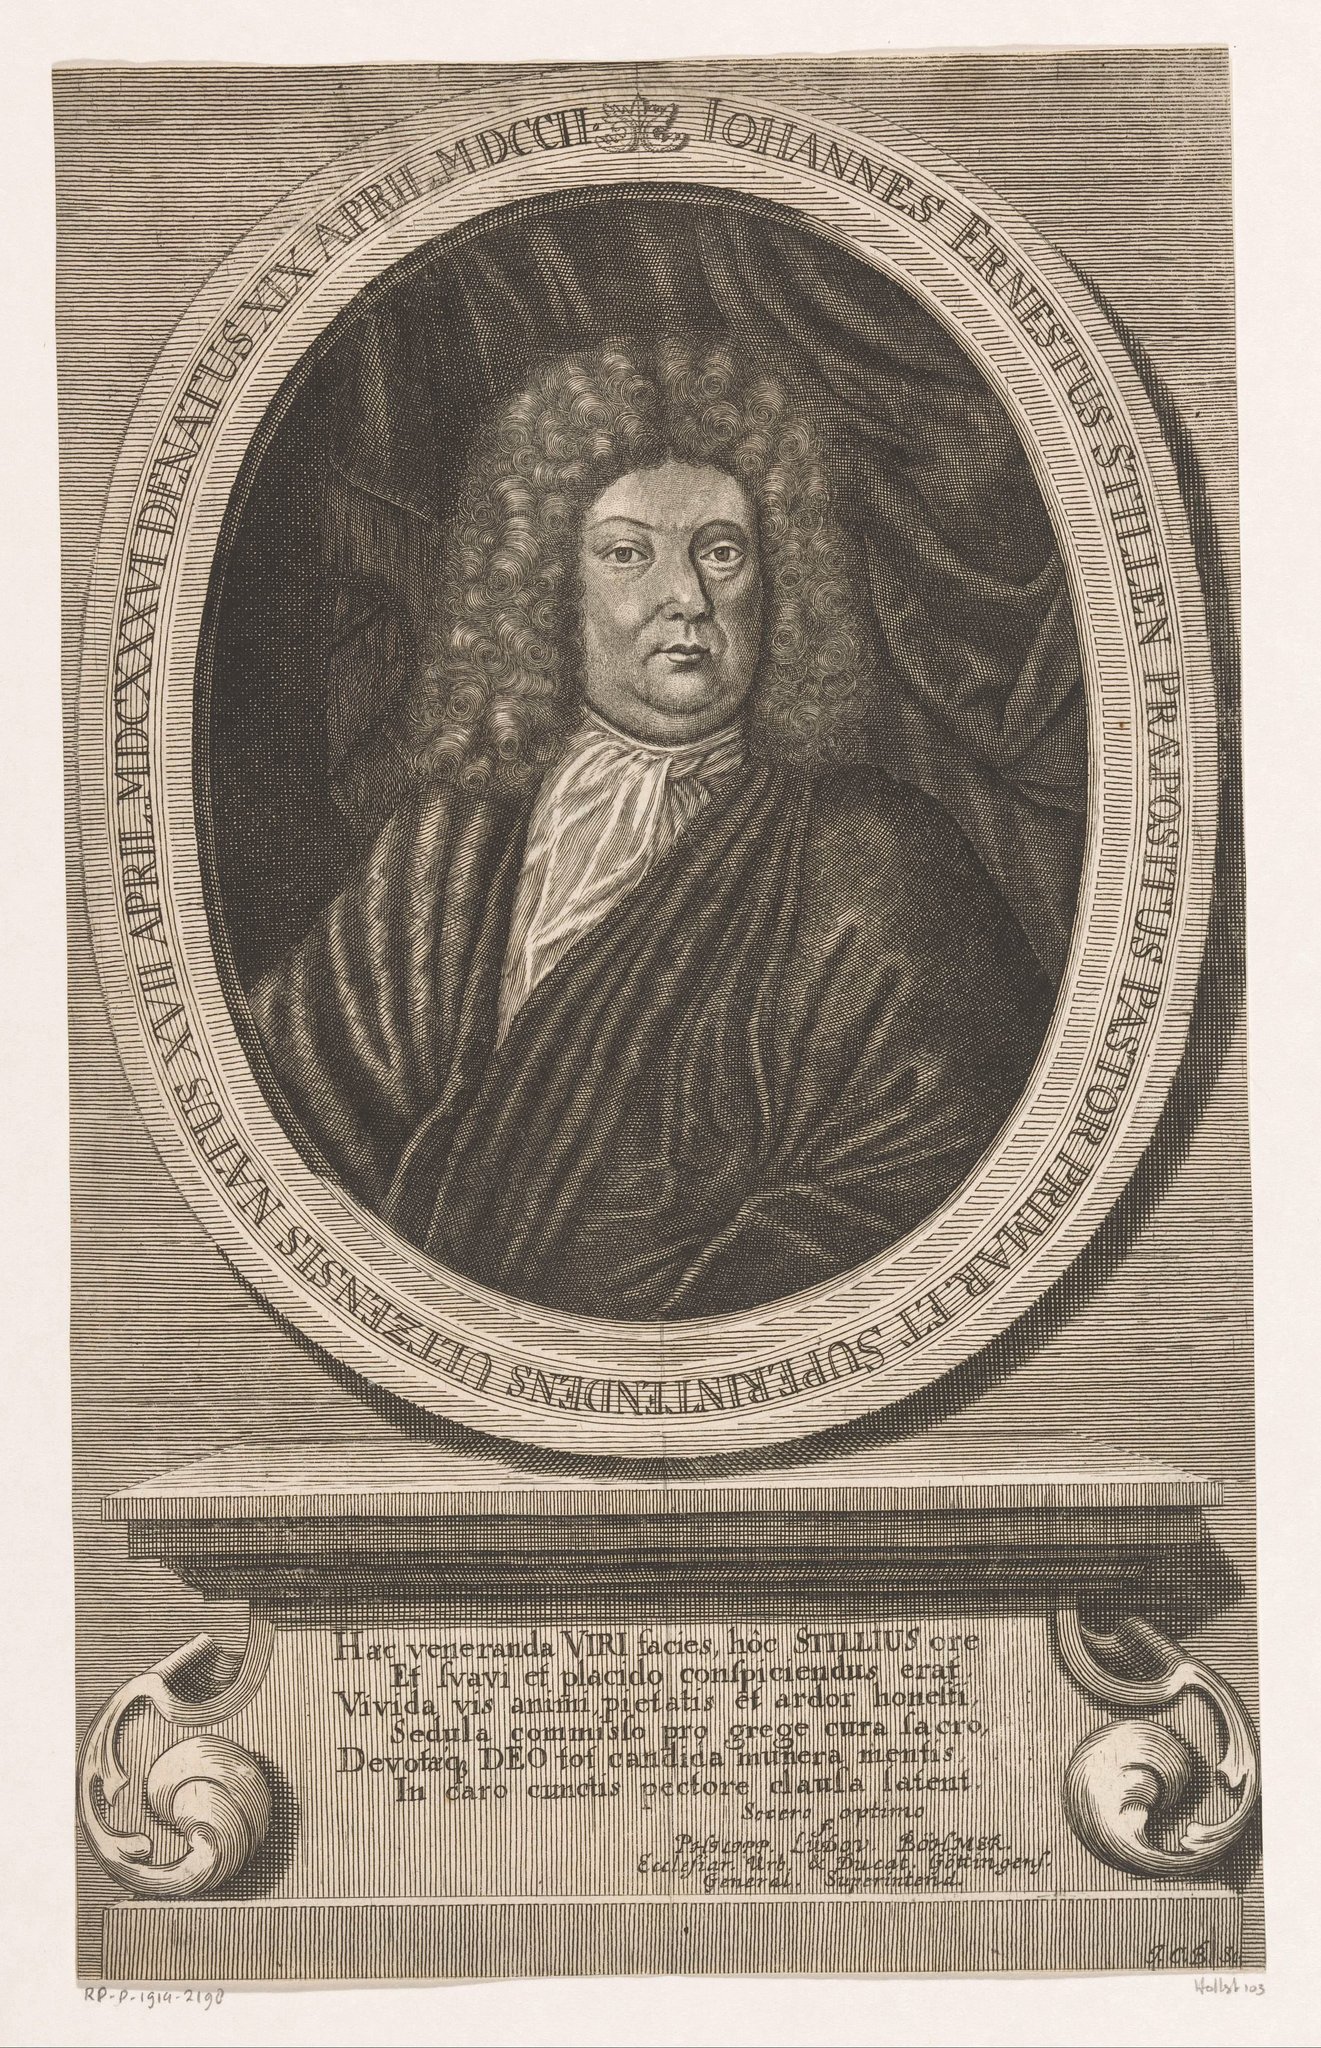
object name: print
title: Portret van Johann Ernst Stille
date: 1702-1709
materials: paper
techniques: engraving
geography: gottingen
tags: historical persons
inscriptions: collector's mark: Lugt 2228